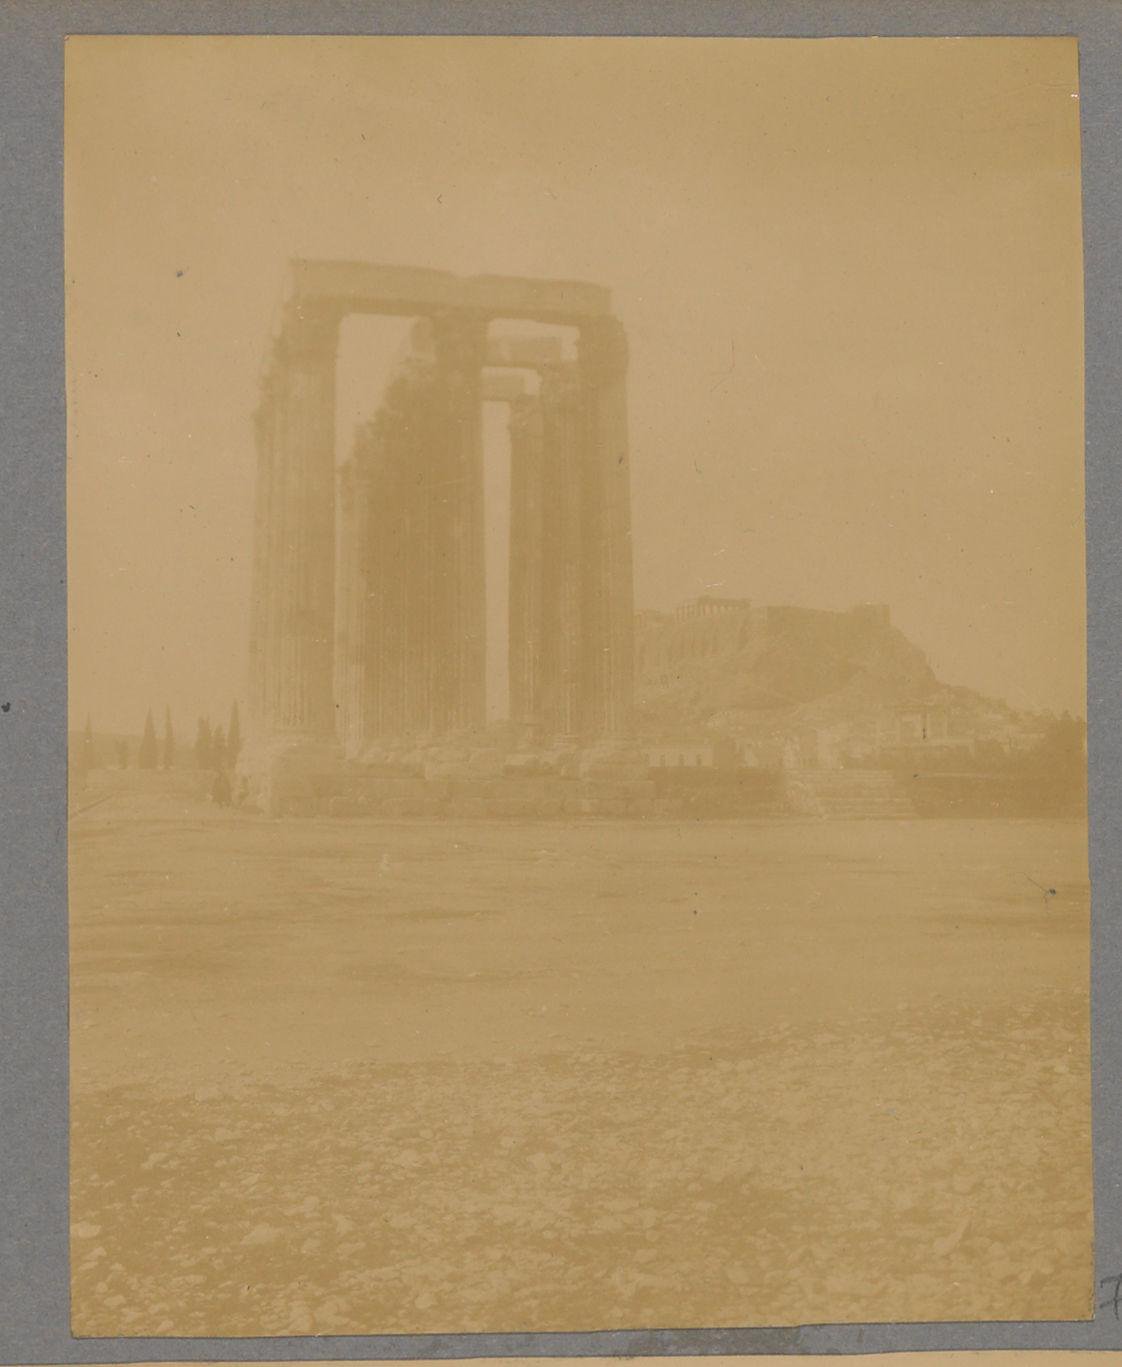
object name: photograph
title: Gezicht op de Tempel van de Olympische Zeus in Athene met op de achtergrond de Akropolis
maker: Anonymous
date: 1905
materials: paper, photographic support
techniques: gelatin silver print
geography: athens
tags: temple, shrine ~ greek religion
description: Onderdeel van Reisalbum met foto's van bezienswaardigheden in Griekenland en Egypte.